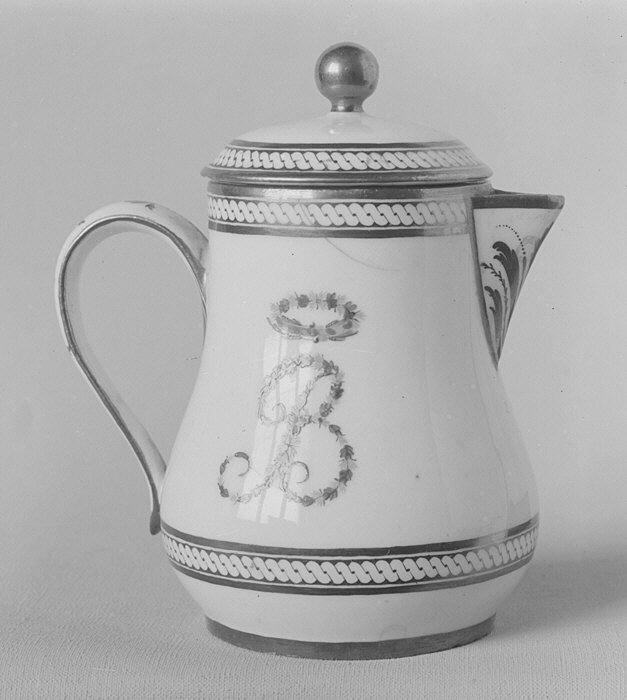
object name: milk jug with cover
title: Milk jug with cover (part of a traveling tea service)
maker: dihl et guérhard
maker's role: factory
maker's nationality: french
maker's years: 1781-1824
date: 1788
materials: hard paste porcelain